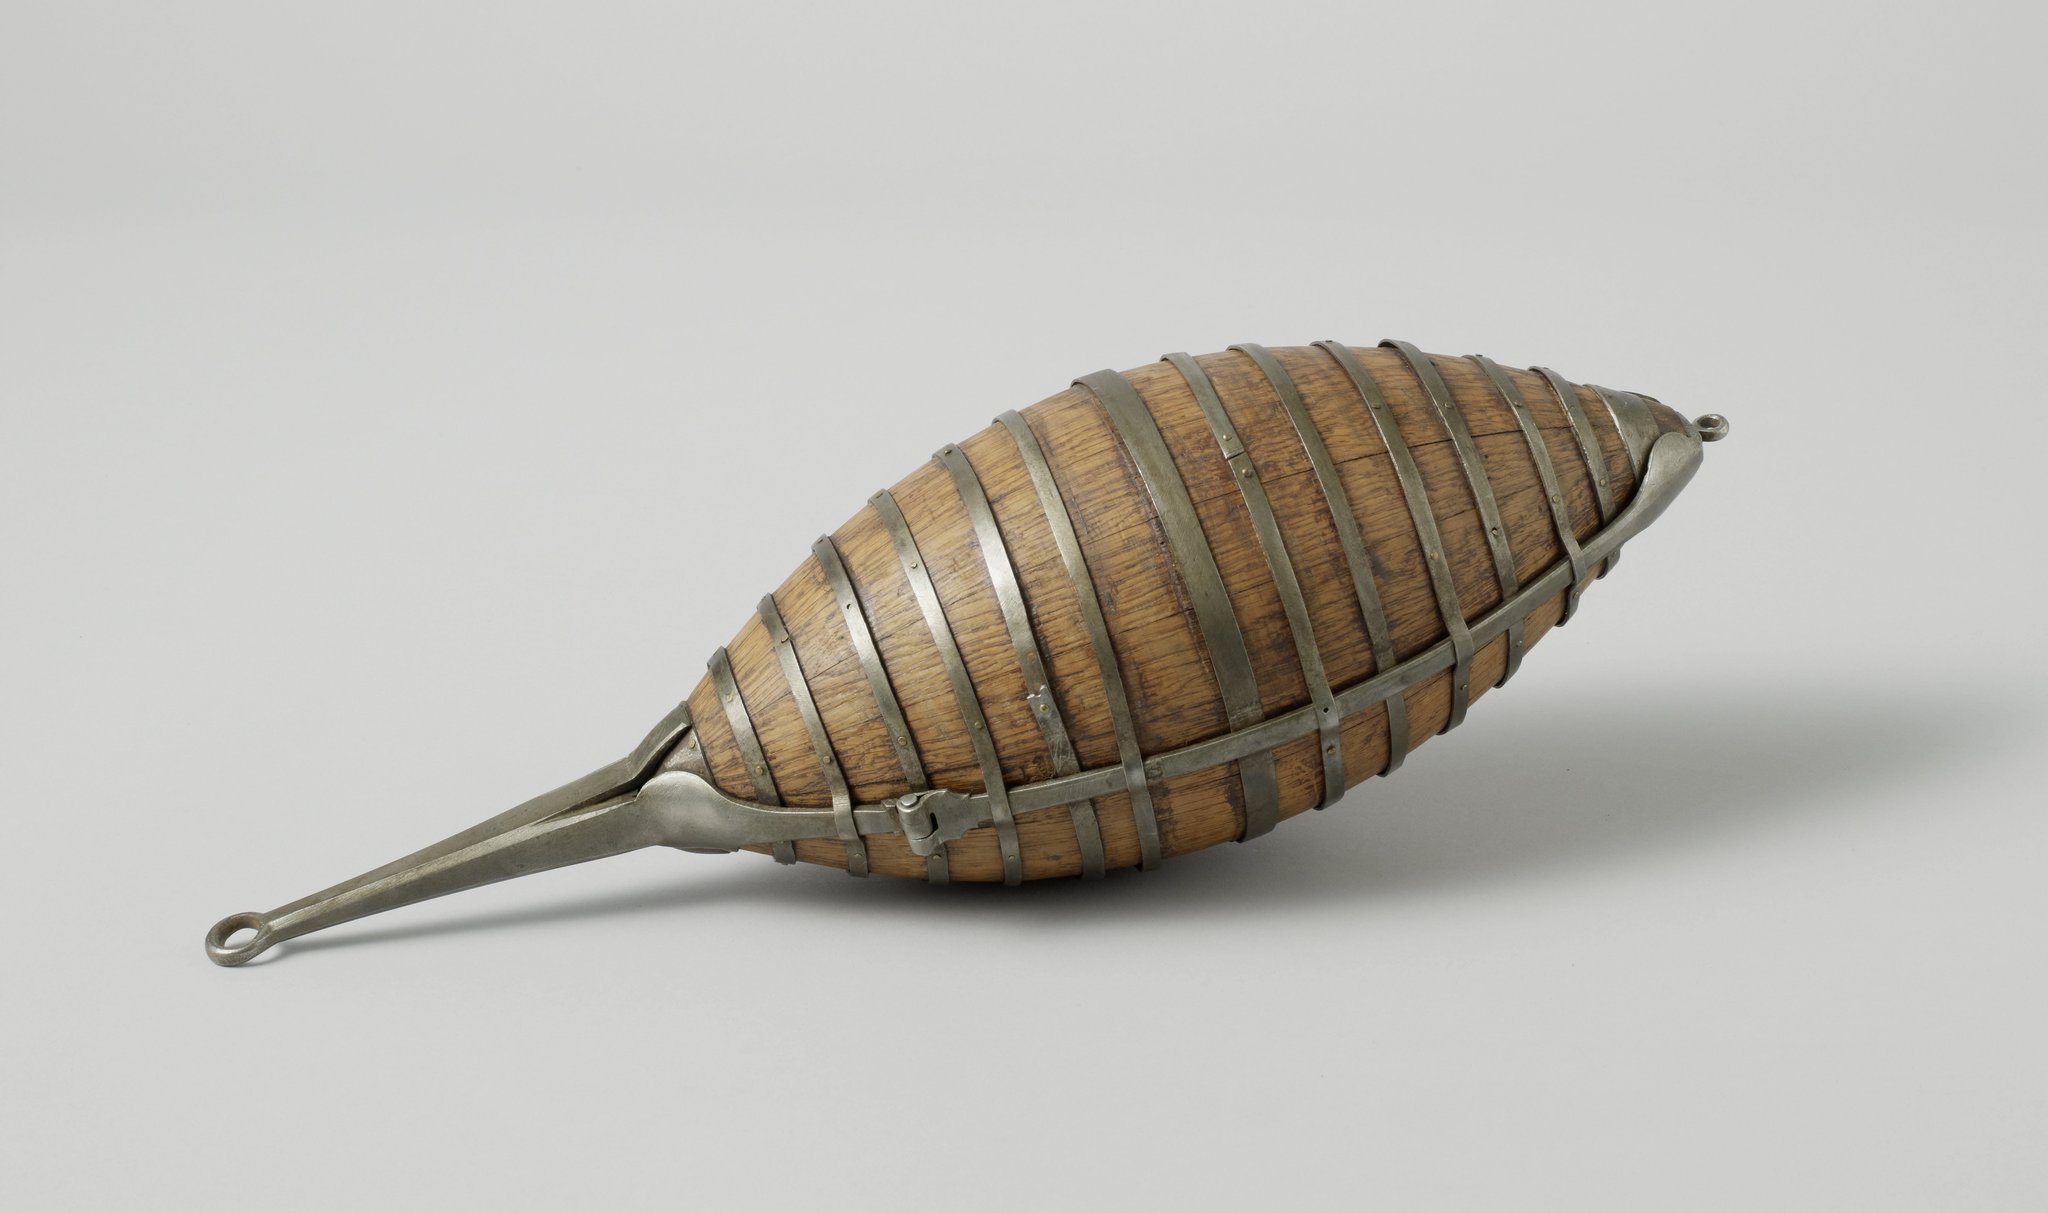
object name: demonstration model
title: Model of a Buoy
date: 1873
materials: iron, wood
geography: enkhuizen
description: Model van een boei met een conisch lichaam met scherpe uiteinden en rond van doorsnee. Zoals een vat is zij samengesteld uit duigen en hoepels. Aan een eind zit een oog, aan het andere eind een lange punt met oog waarschijnlijk voor de ankerketting. Schaal 1:10 (archief).